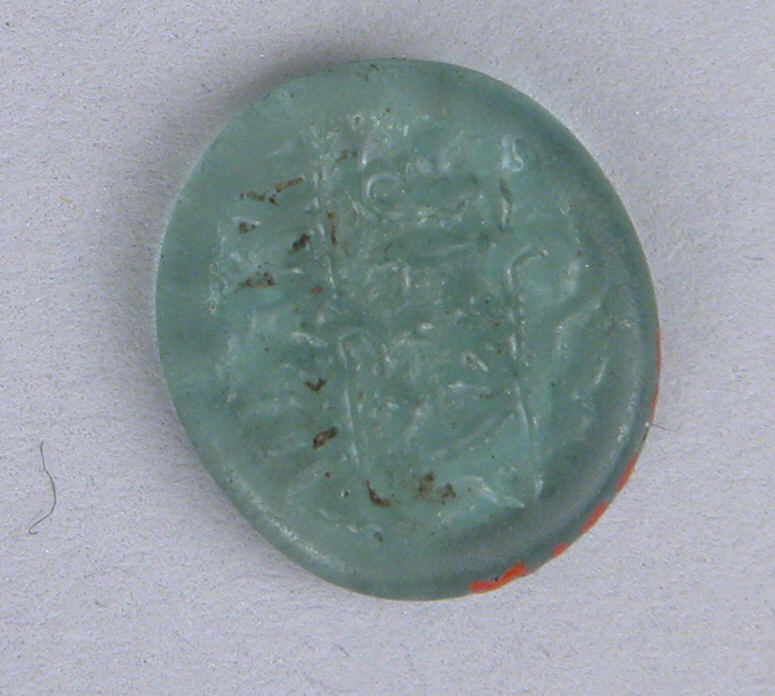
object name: coin weight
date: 901-1100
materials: glass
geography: egypt